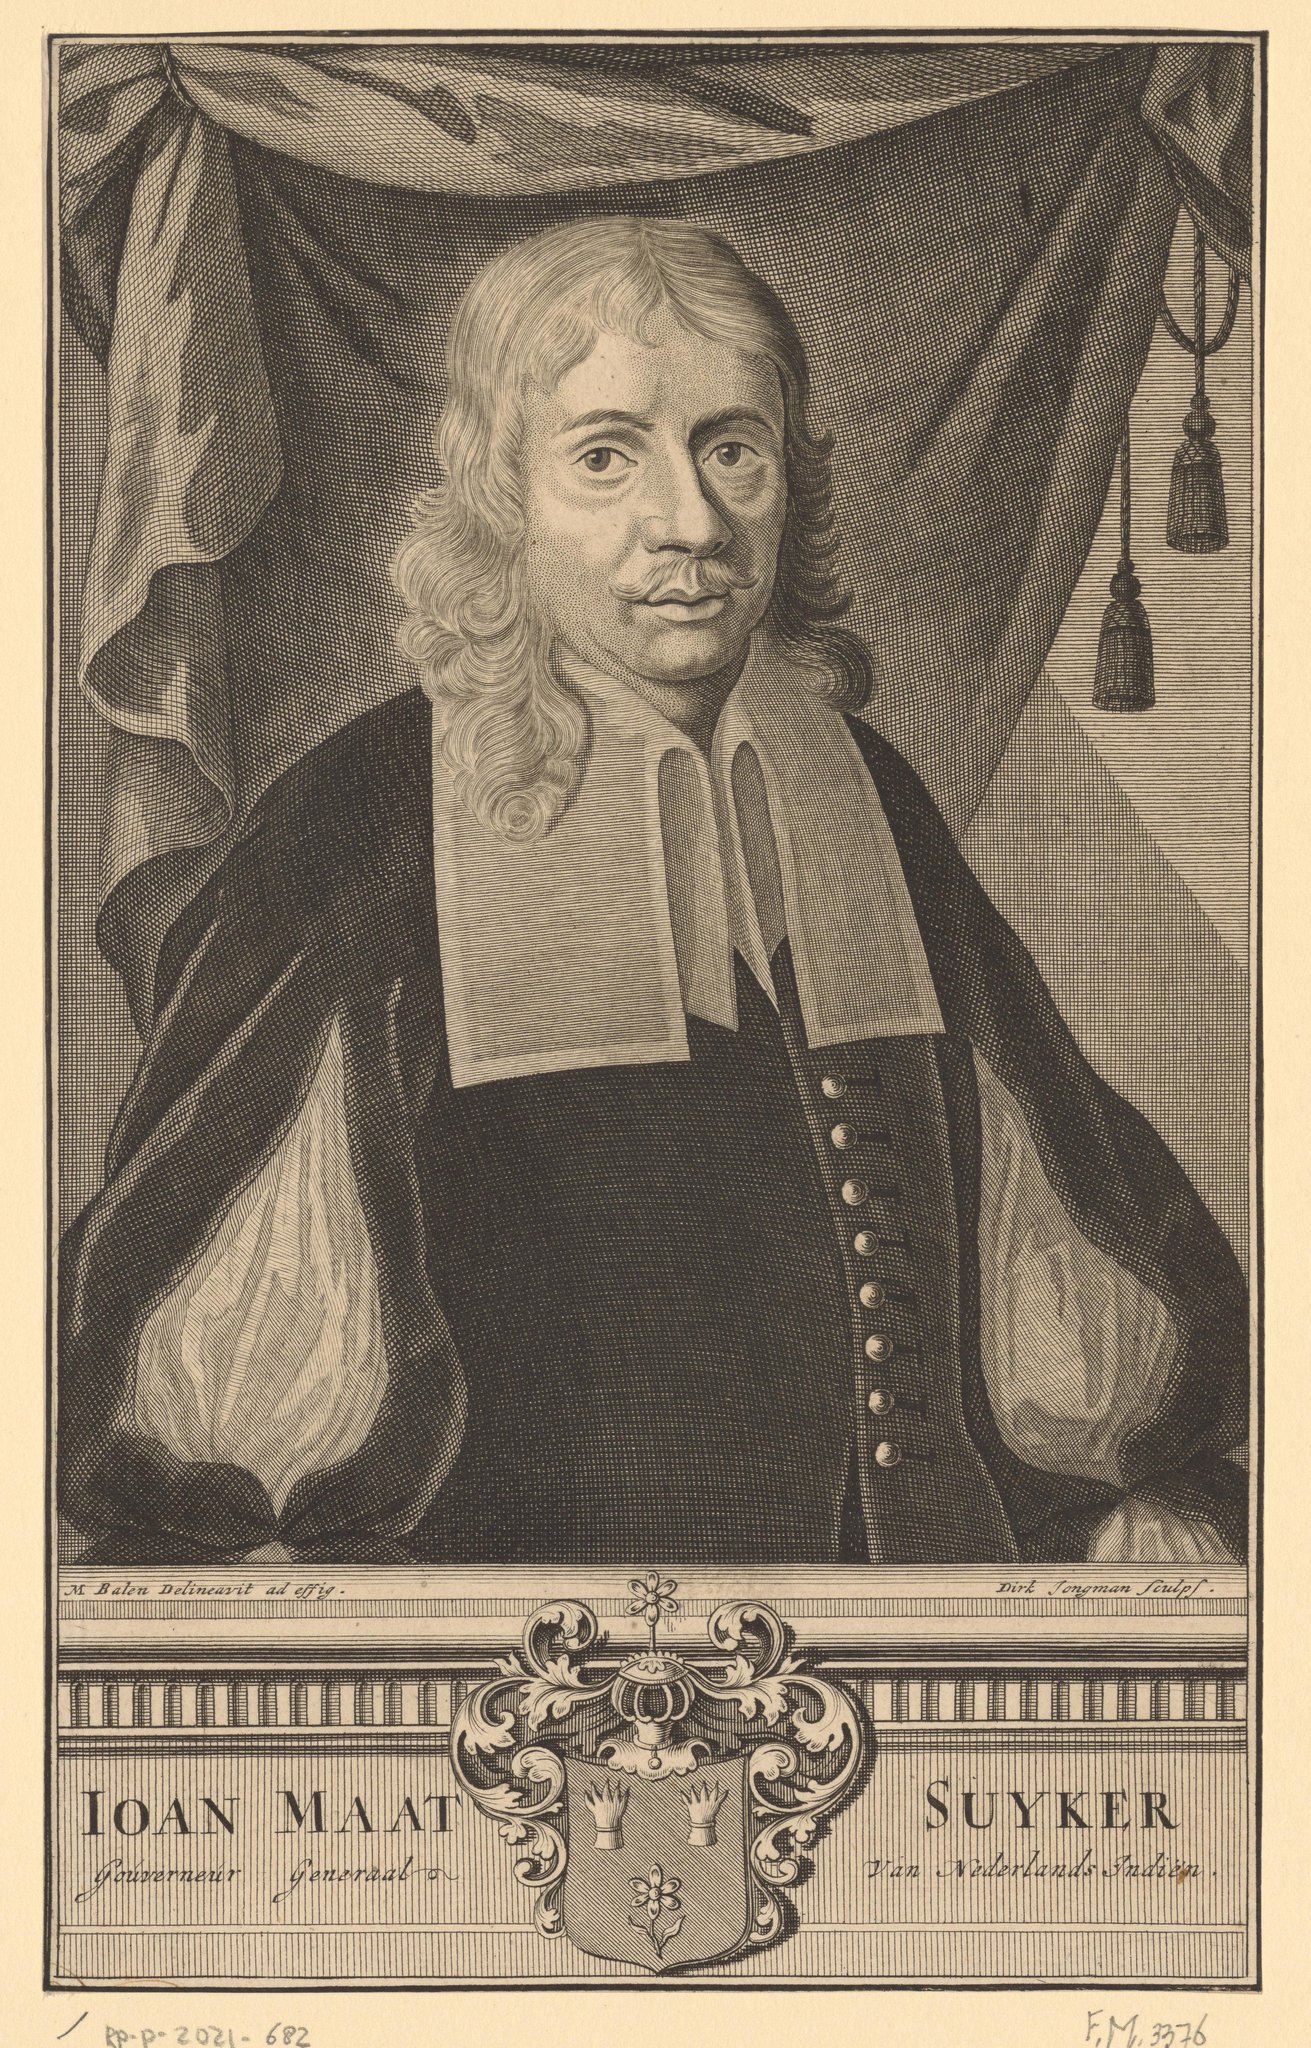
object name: print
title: Portret van Joan Maetsuycker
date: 1694-1726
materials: paper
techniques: engraving, etching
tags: batavia, official; civil servant; functionary (in general), historical persons, lawyer, attorney at law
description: Zoals vermeld op een exemplaar van deze prent in oversneden staat, is deze prent mogelijk uitgegeven door Johannes van Braam (tussen 1702-1744 werkzaam in Dordrecht) en Gerard onder de Linden (tussen 1711-1727 werkzaam in Amsterdam).